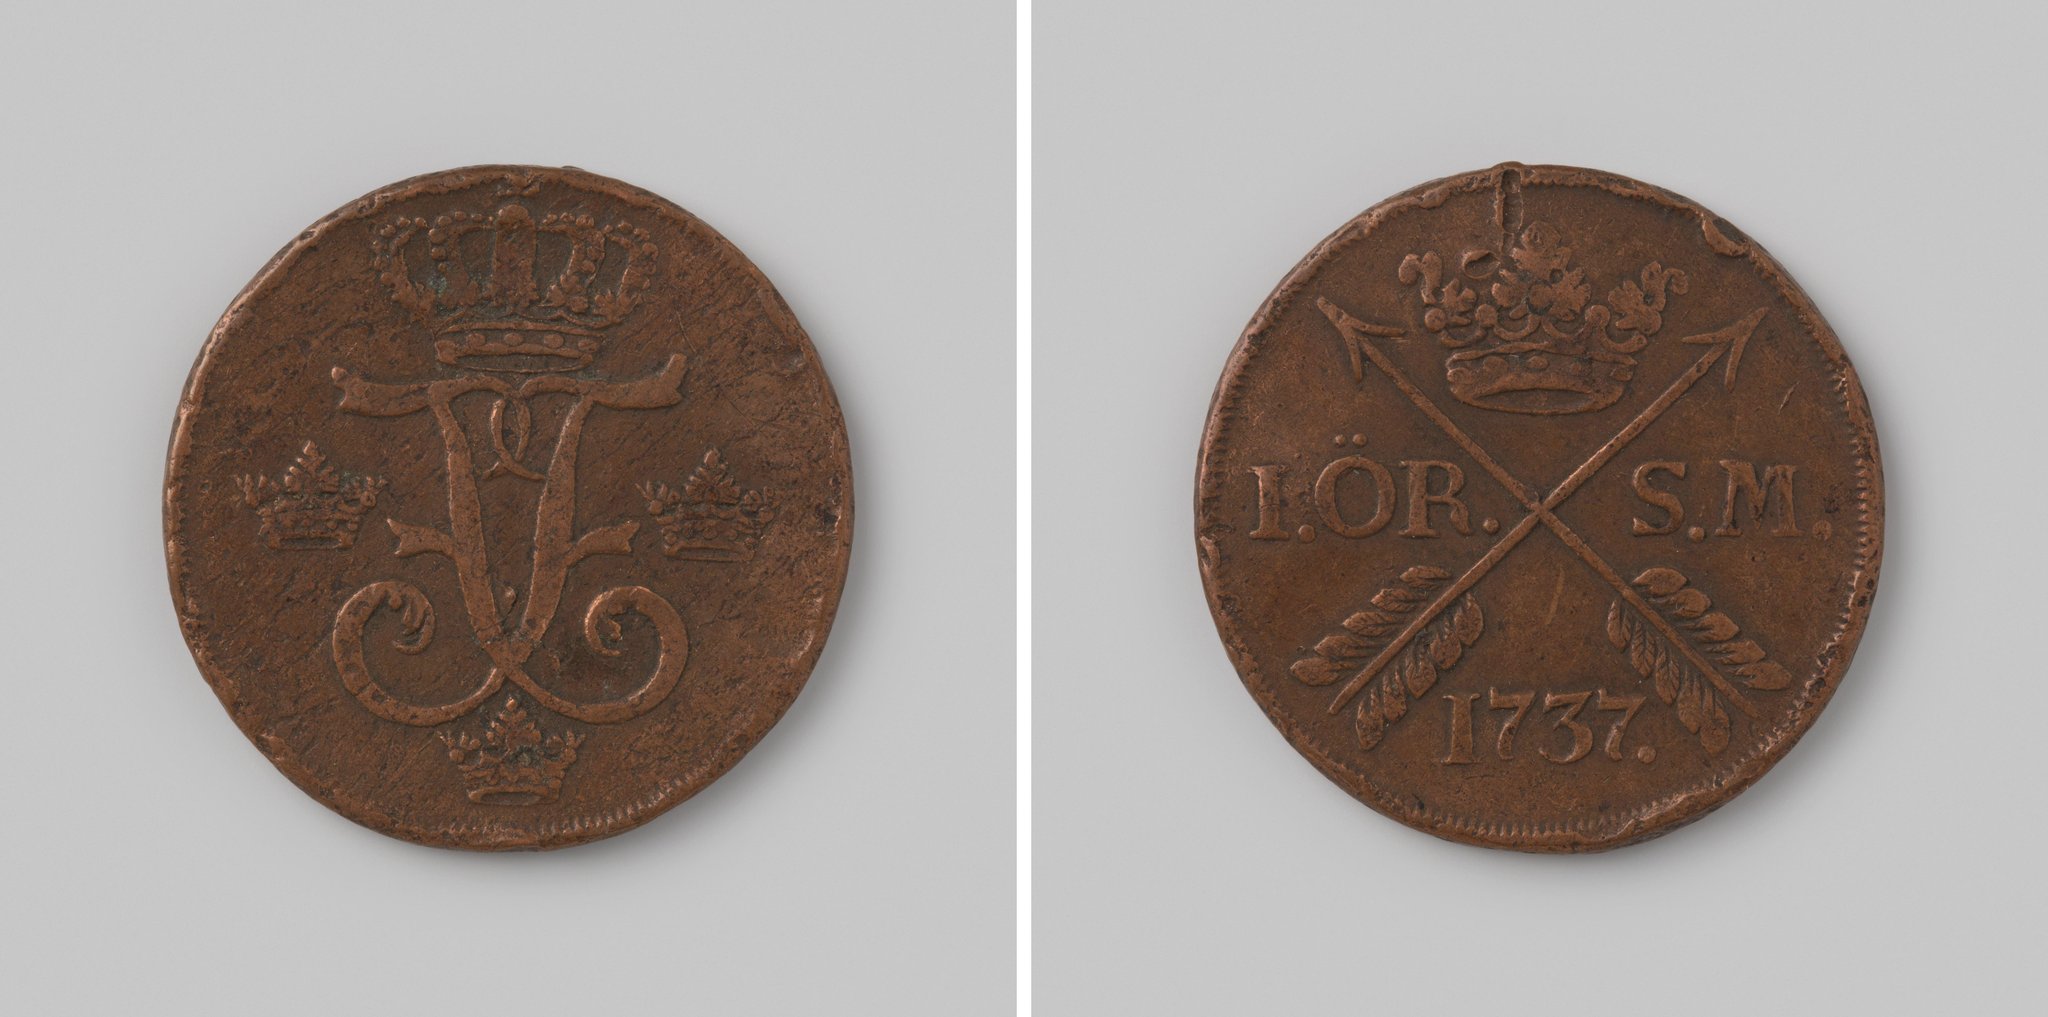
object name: coin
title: Zweden, Frederik I, öre S[ilver] M[ynt],1737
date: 1737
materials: copper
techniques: striking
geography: slot rörstrand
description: Koperen munt. Voorzijde: tussen drie kronen monogram van twee letters F. Daaboven koningskroon. Keerzijde: twee gekruiste pijlen, waarboven kroon wen waaronder jaartal. Waarde-aanduiding in veld. Kabelrand.